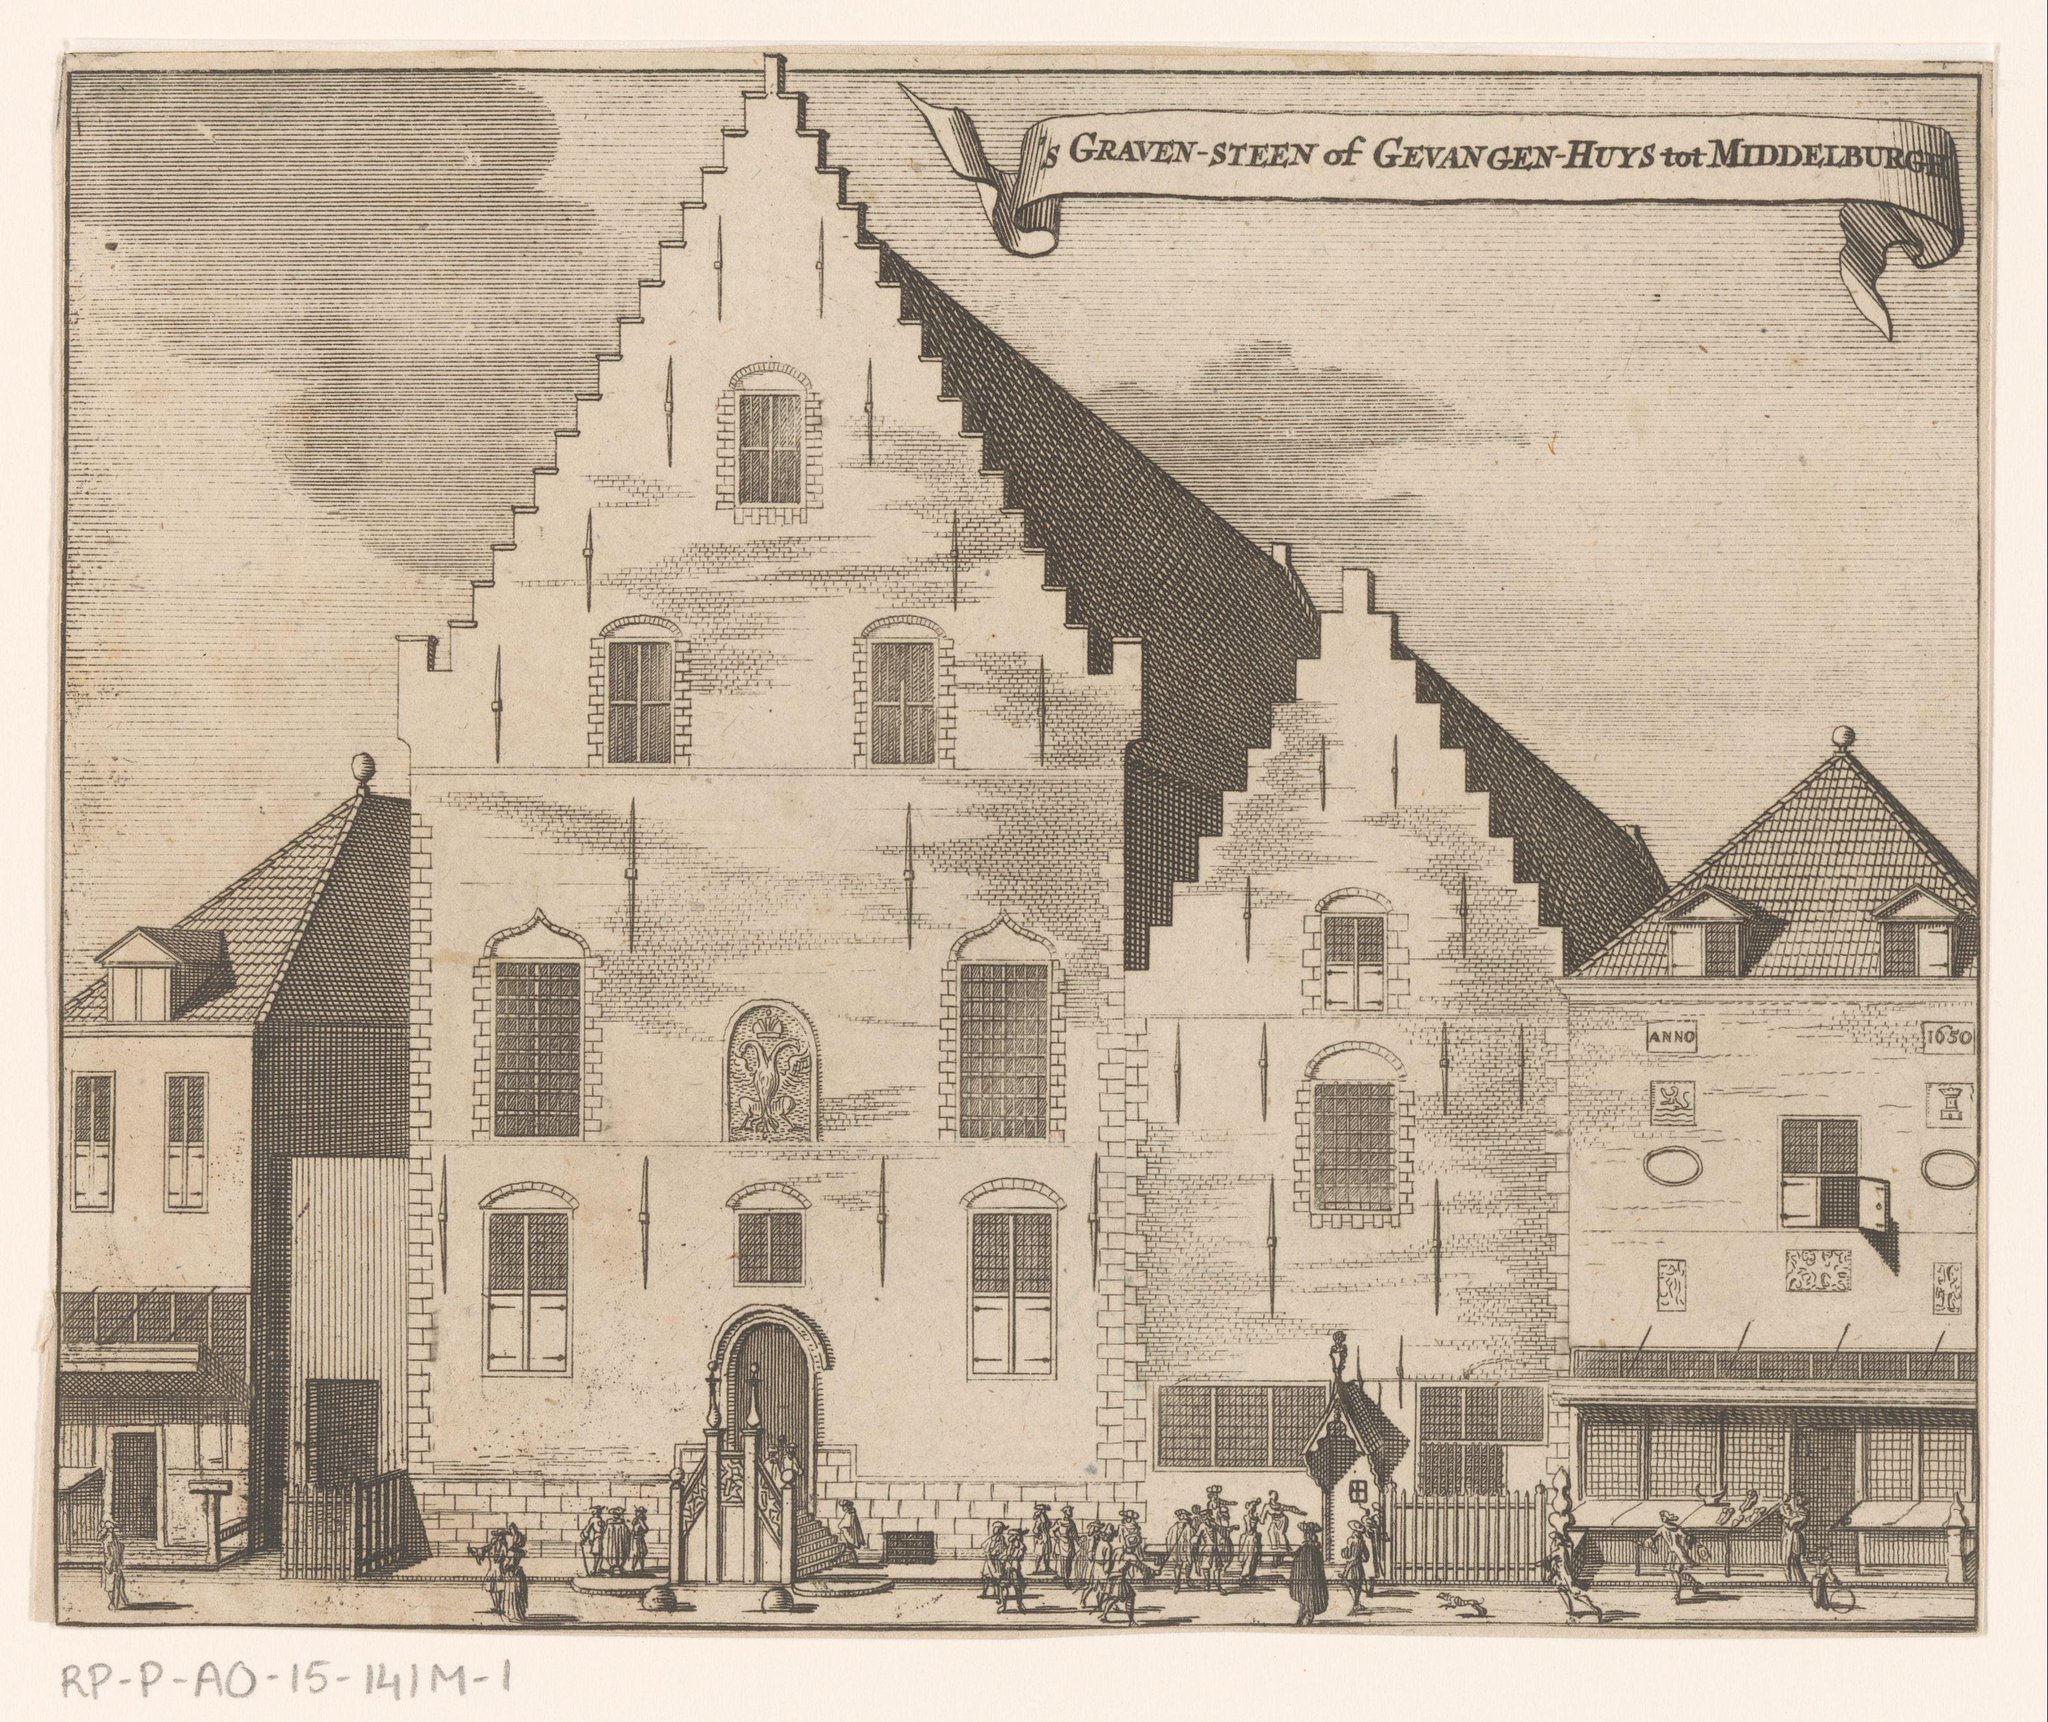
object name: book illustration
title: 's Graven-steen of Gevangen-Huys tot Middelburgh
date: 1696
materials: paper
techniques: engraving, etching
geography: middelburg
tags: prison, jail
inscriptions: collector's mark: Lugt 195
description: Oorspronkelijk van één plaat gedrukt met drie andere voorstellingen (zie RP-P-AO-15-141K-2, RP-P-AO-15-141L-1-1 en RP-P-AO-15-141N-2-1). Prent in zijn geheel ook gebruikt in: Smallegange, Mattheus. Nieuwe Cronyk van Zeeland (…). Middelburg en Amsterdam: Johannes Meertens en Abraham van Someren, 1696. Huidige voorstelling later (plaat mogelijk versneden) met andere voorstelling van zelfde plaat en apart gedrukte sierrand ook gebruikt in: Aa, Pieter van der. La galerie agreable du monde (...). 66 delen. Leiden: Pieter van der Aa, 1728, dl. 20.